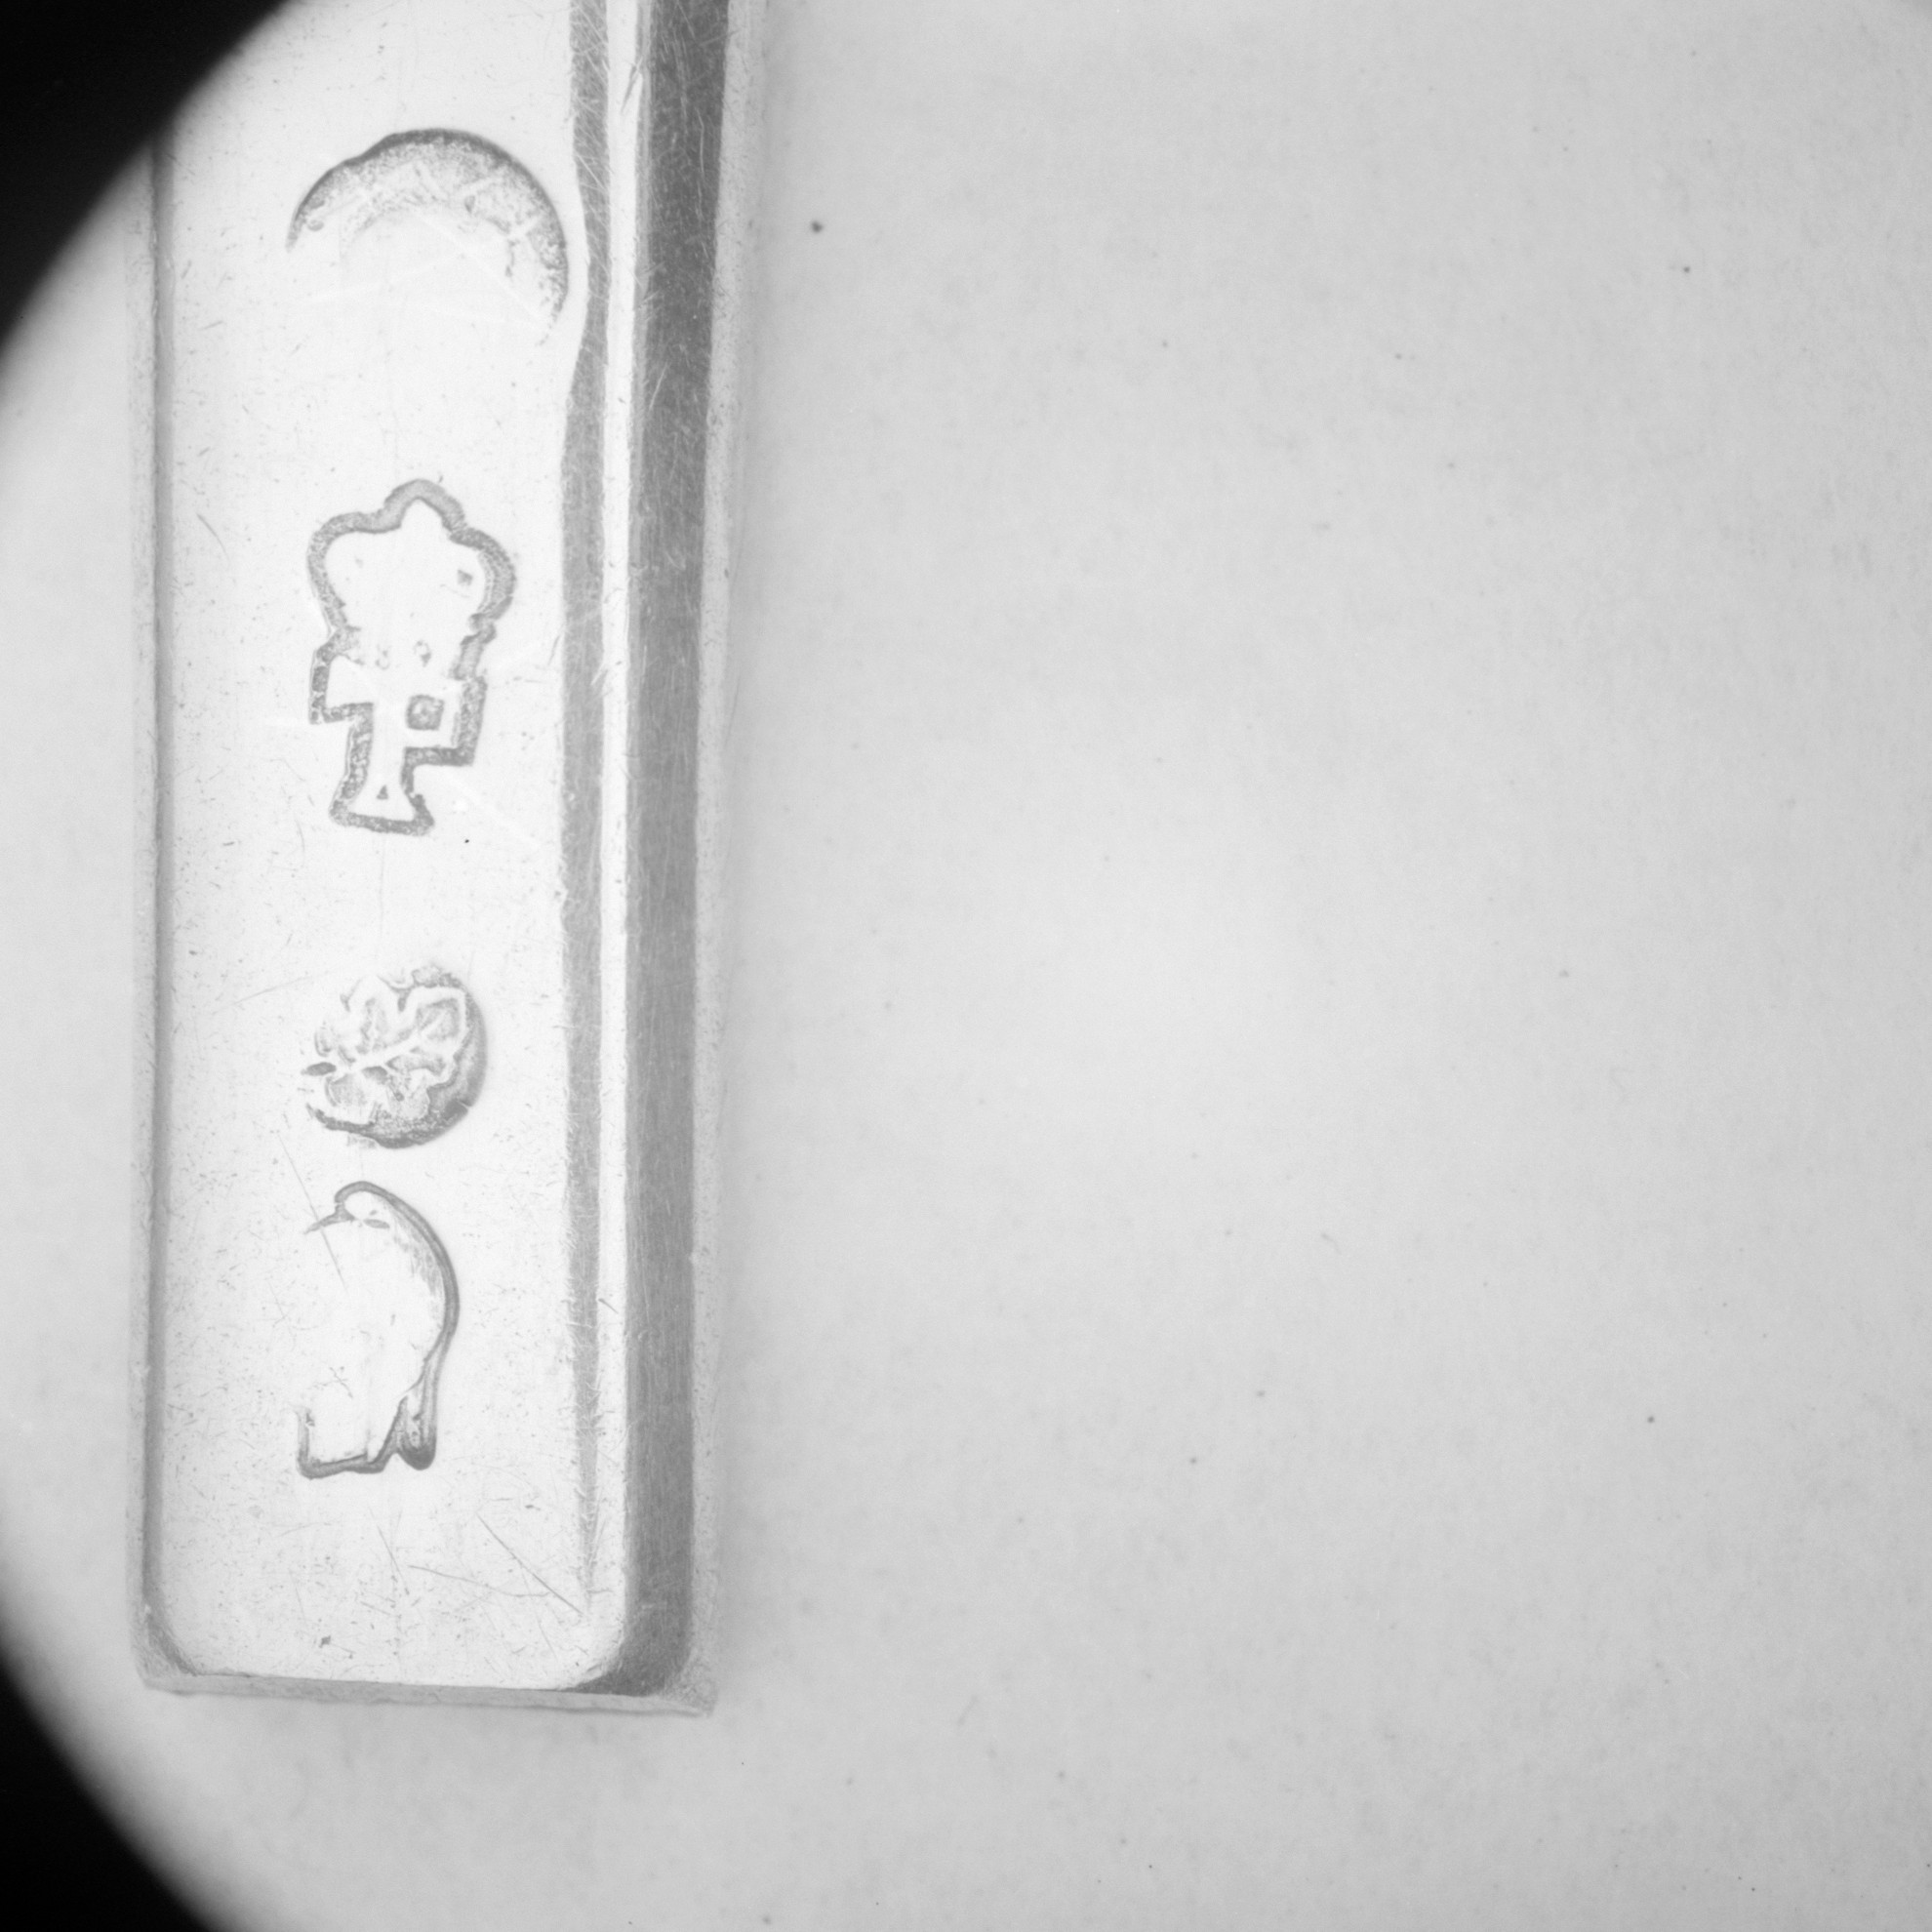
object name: spoon handle section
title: Section of a spoon handle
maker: michel savigny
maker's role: maker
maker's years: 1751-1823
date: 1789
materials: silver